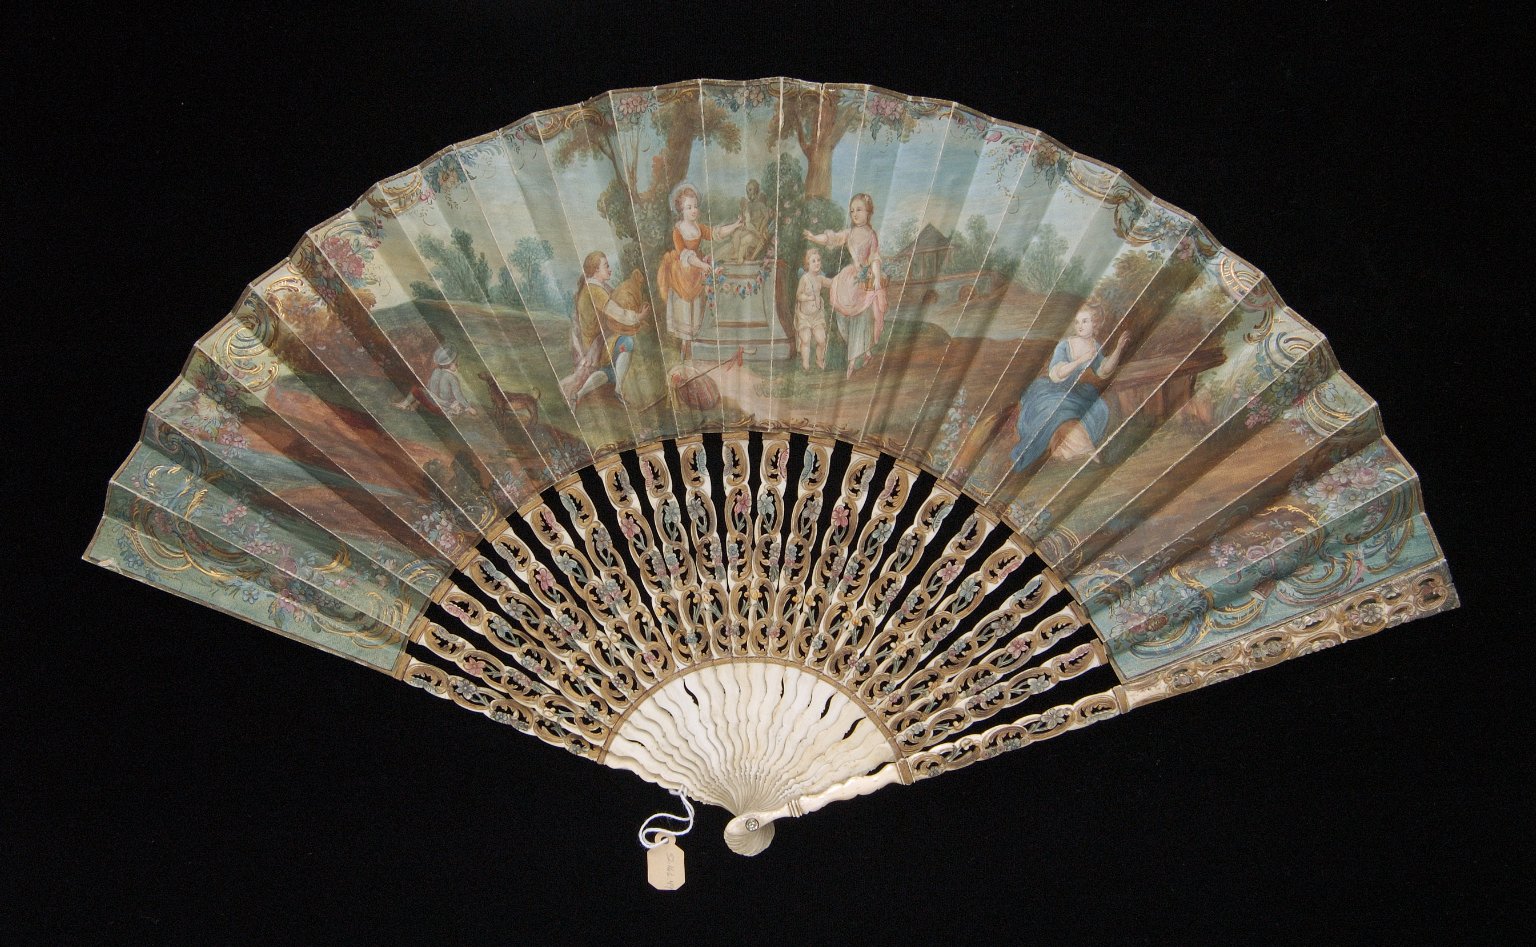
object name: fan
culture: french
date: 1776-1800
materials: glass, ivory, paper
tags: animals,men,women